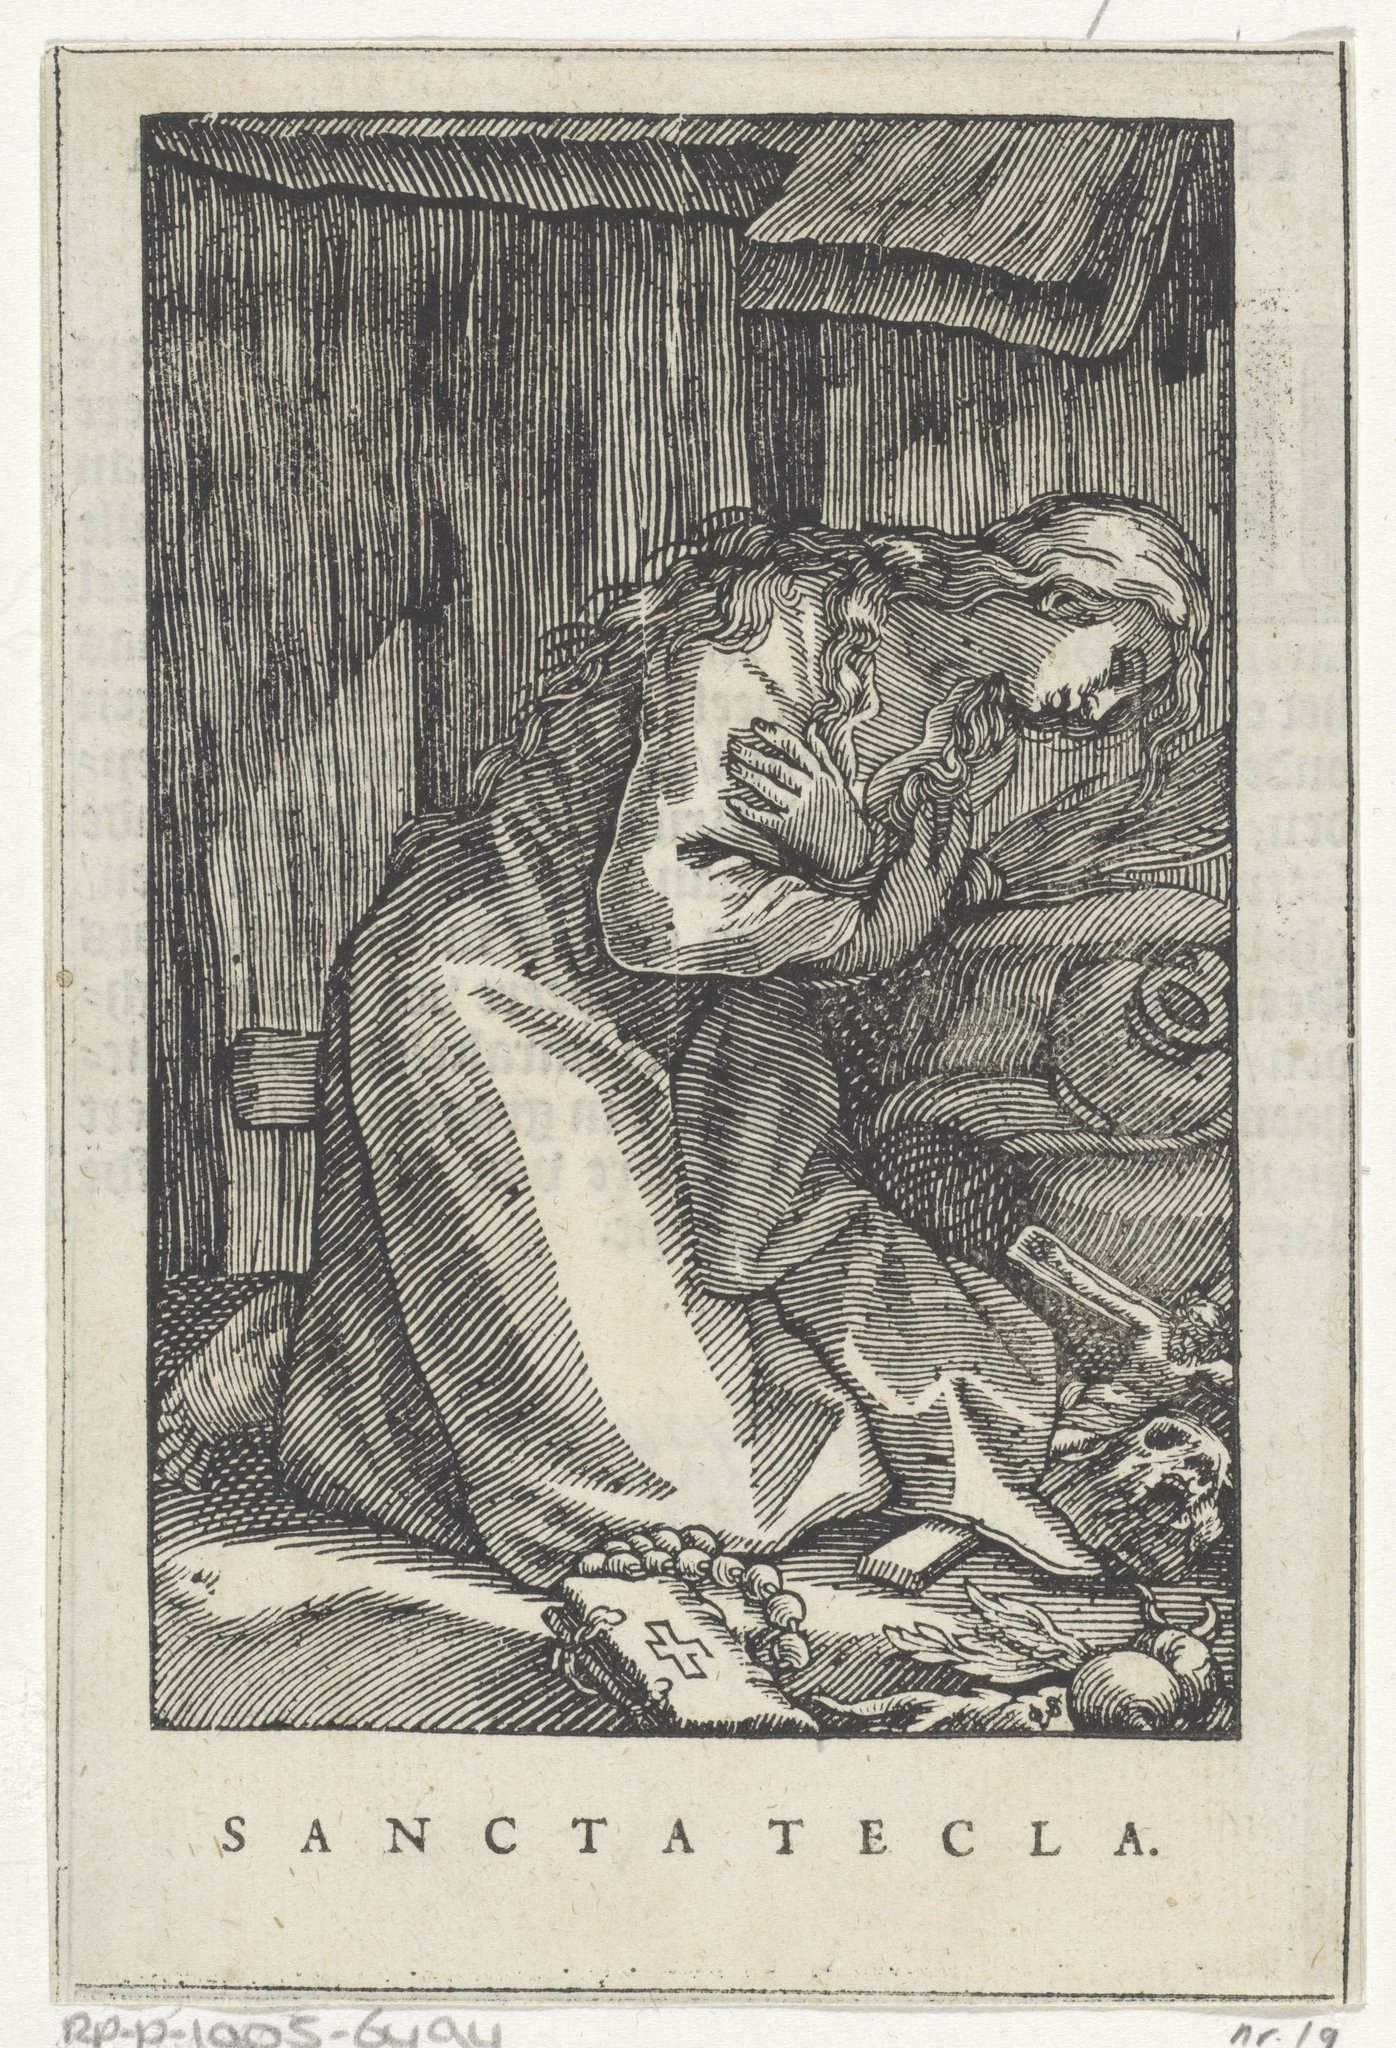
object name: print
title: Sancta Tecla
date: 1644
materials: paper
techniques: letterpress printing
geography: amsterdam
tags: the virgin martyr thecla of iconium; possible attributes: bear, (ball of) flames, lion, pillar, serpents, anchorite, hermit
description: Prent uit: Rosweyde, Heribert. 'tBosch der eremyten ende eremitinnen, van Aegypten ende Palestinen. Amsterdam: Pieter Jacobsz. Paets, 1644.